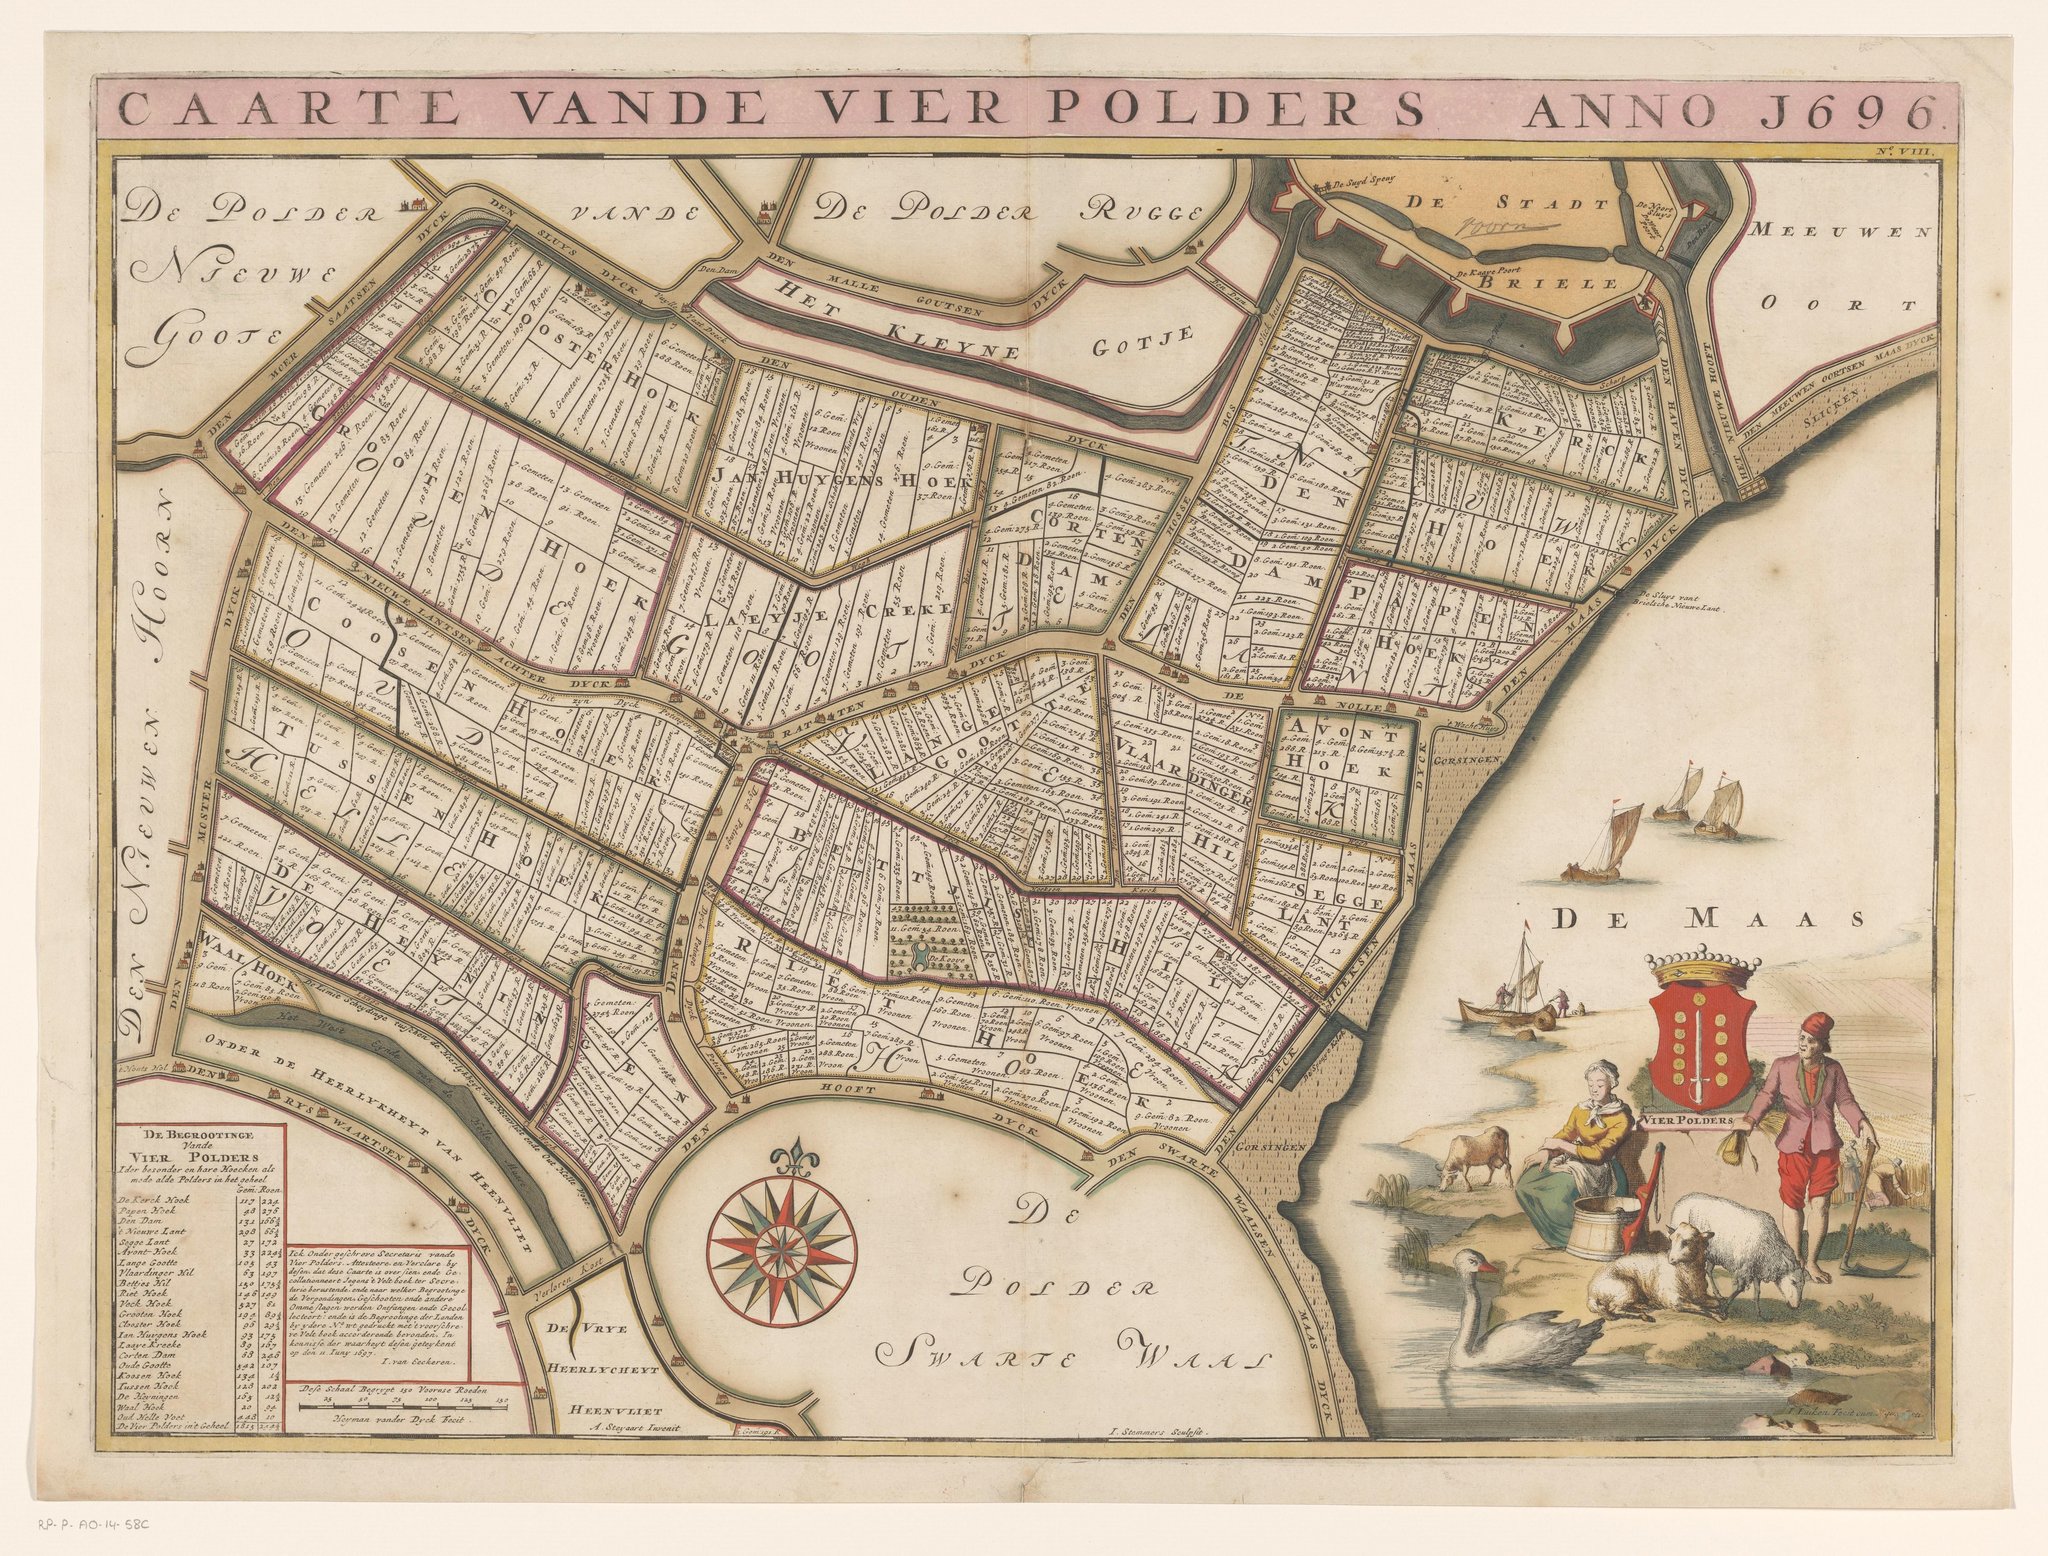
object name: print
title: Voorne Caart-boeck / Caartboeck van Voorne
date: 1701-1729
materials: paper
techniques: engraving, etching, hand coloring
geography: amsterdam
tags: coat of arms (as symbol of the state, etc.), maps of separate countries or regions, water-birds: swan, farmers, sheep, polder, reclaimed land, fisherman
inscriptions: collector's mark: Lugt 19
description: Deze kaart is onderdeel van het zogenaamde 'Voorne Caart-boeck' / 'Caartboeck van Voorne', dat bestaat uit een titelpagina (zie RP-P-1942-347), drie algemene kaarten (van Oost-, West- en Zuid-Voorne)* en dertig detailkaarten. Het kaartboek werd vervaardigd in opdracht van de Staten van Voorne en werd in 1701 uitgegeven. Een deel van de koperplaten is bewaard gebleven en in de negentiende en twintigste eeuw gebruikt voor herdrukken. *Over de naam Voorne kan verwarring ontstaan omdat de betekenis door de eeuwen heen is veranderd. Vroeger stonden de (voormalige) eilanden Voorne, Goeree en Overflakkee – allen historisch gezien onderdeel van het Land van Voorne – bekend als respectievelijk Oost-, West- en Zuid-Voorne. Afdrukken van de drie algemene kaarten, waaronder deze kaart, zijn ook gebruikt in: Alkemade, Cornelis van en Pieter van der Schelling. Beschryving van de Stad Brielle, en den lande van Voorn (…). Rotterdam: Philippus Losel, 1729.